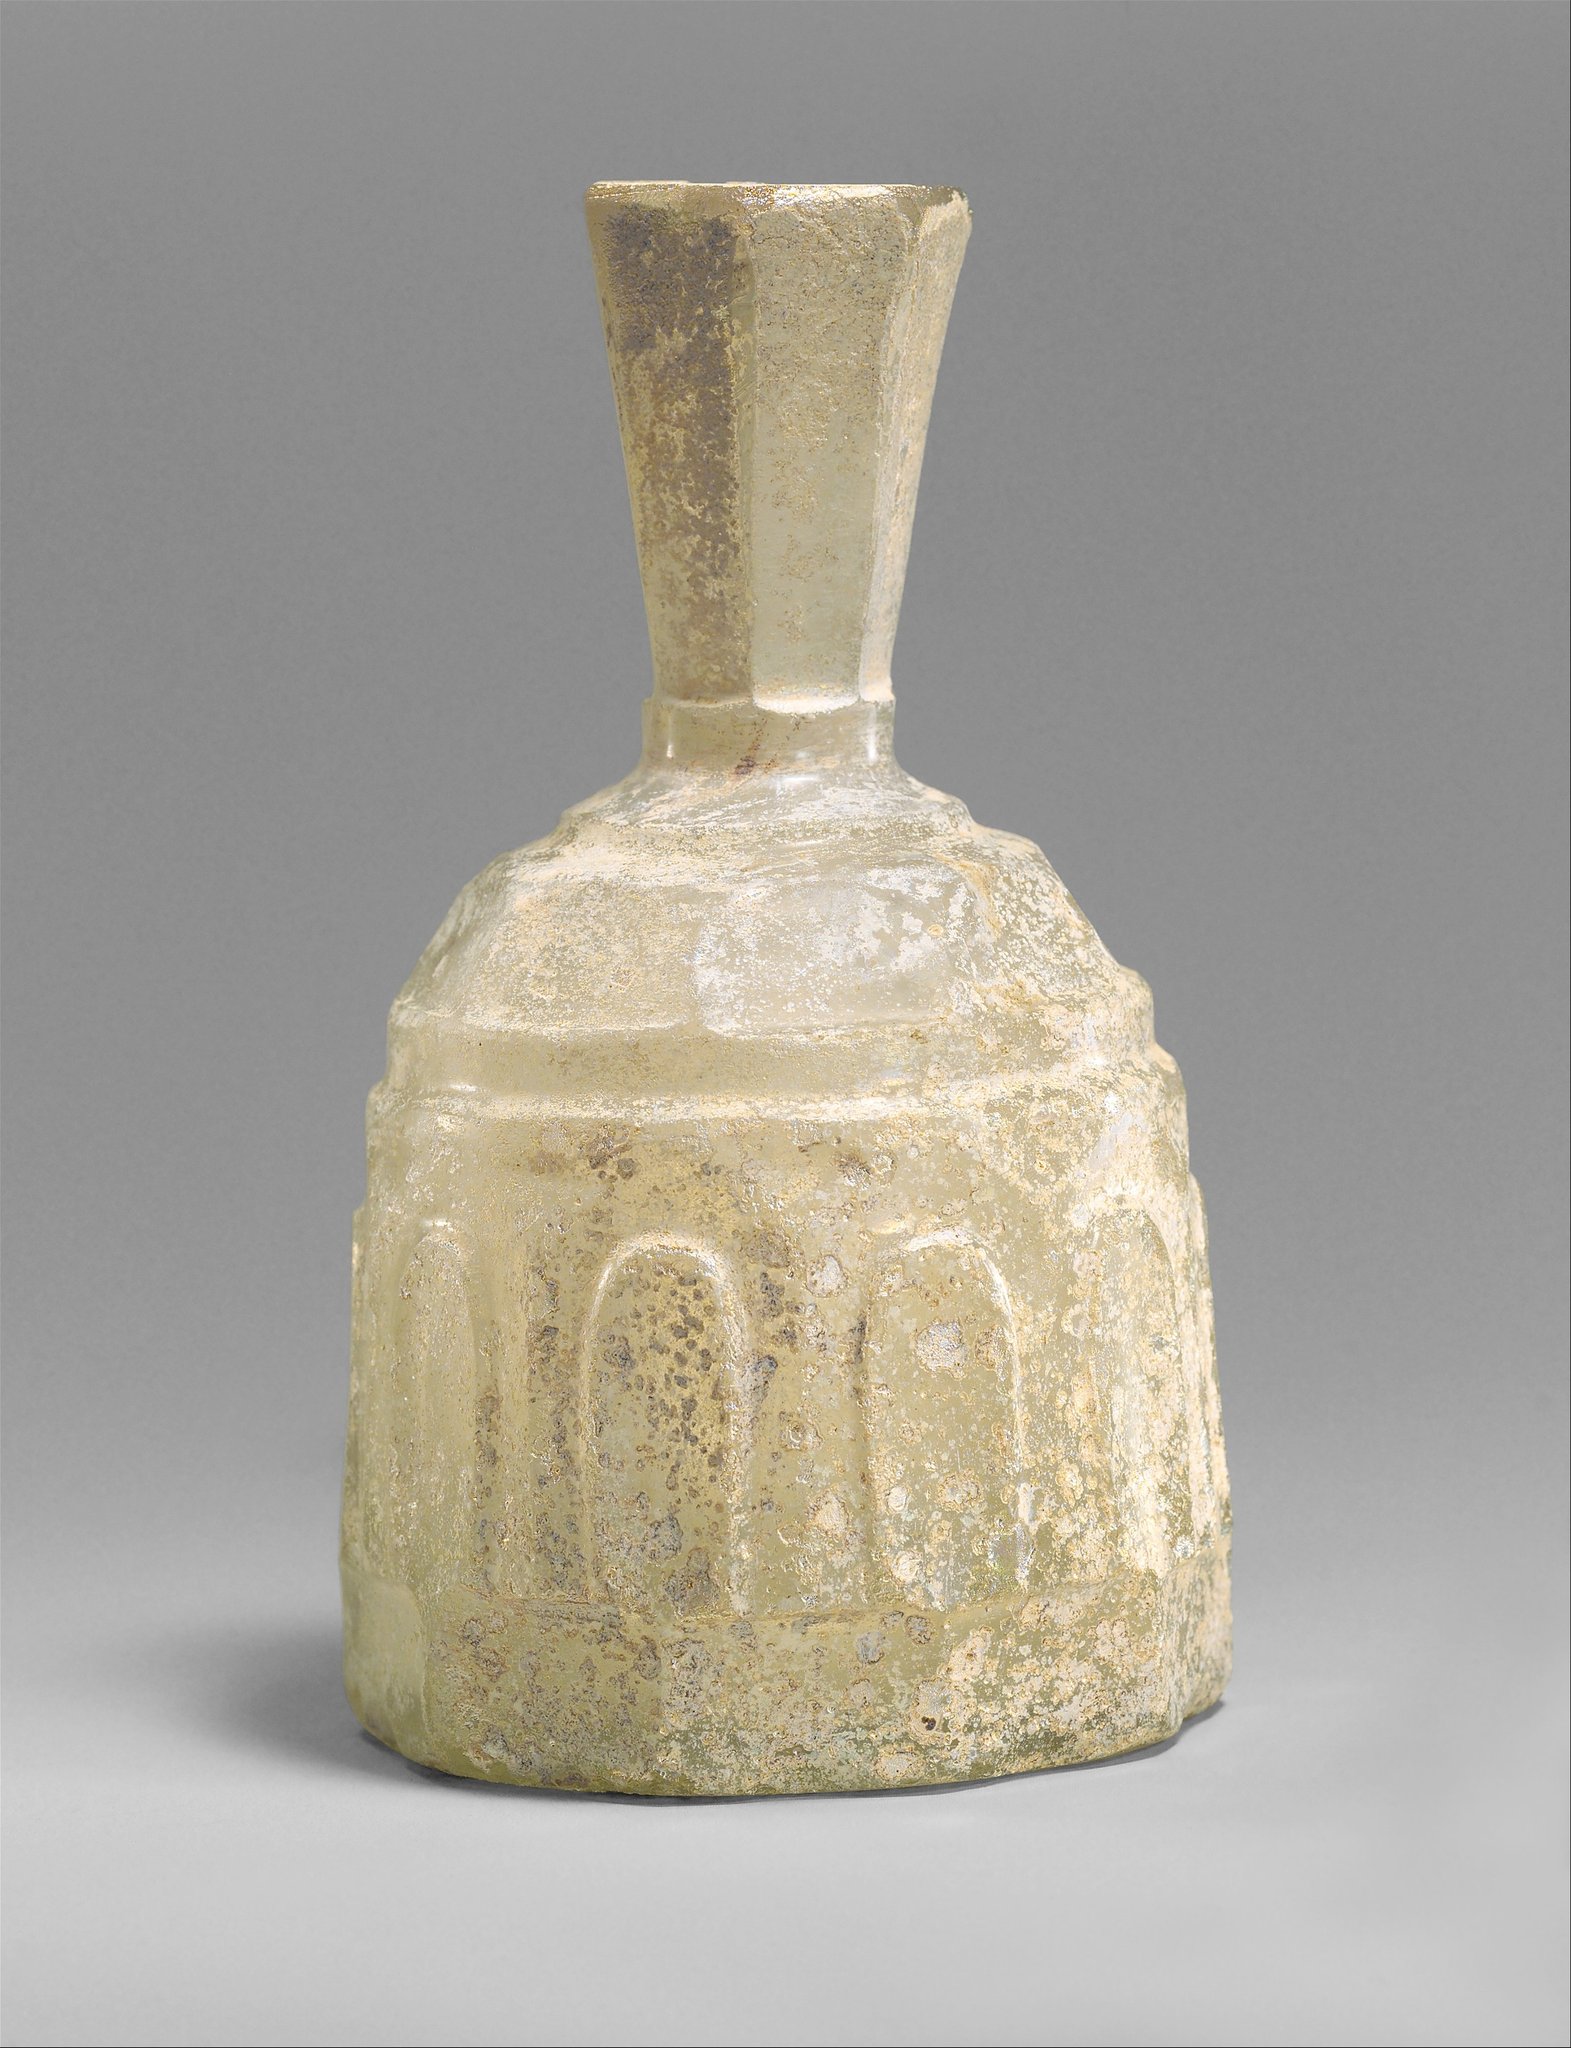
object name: bottle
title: Glass Bottle with Faceted Decoration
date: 801-1000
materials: glass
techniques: glassblowing, cutting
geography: iran